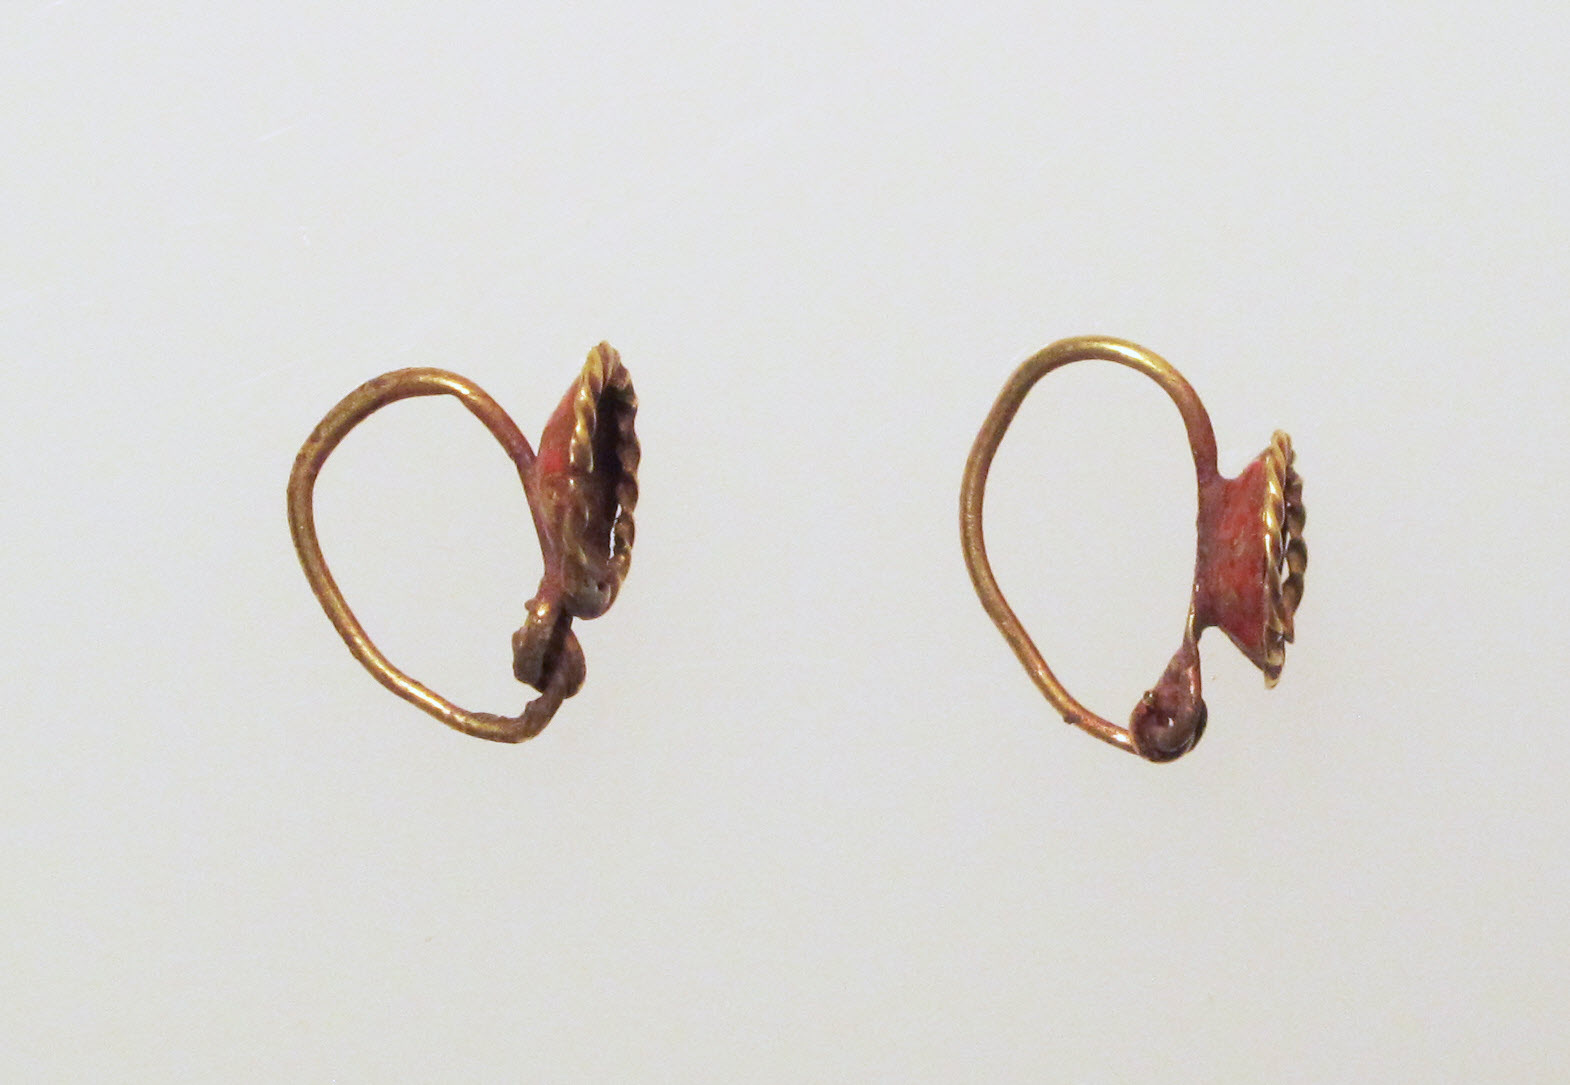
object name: earring loop type, plain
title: Earring, loop type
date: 7000 BCE-330 CE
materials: gold